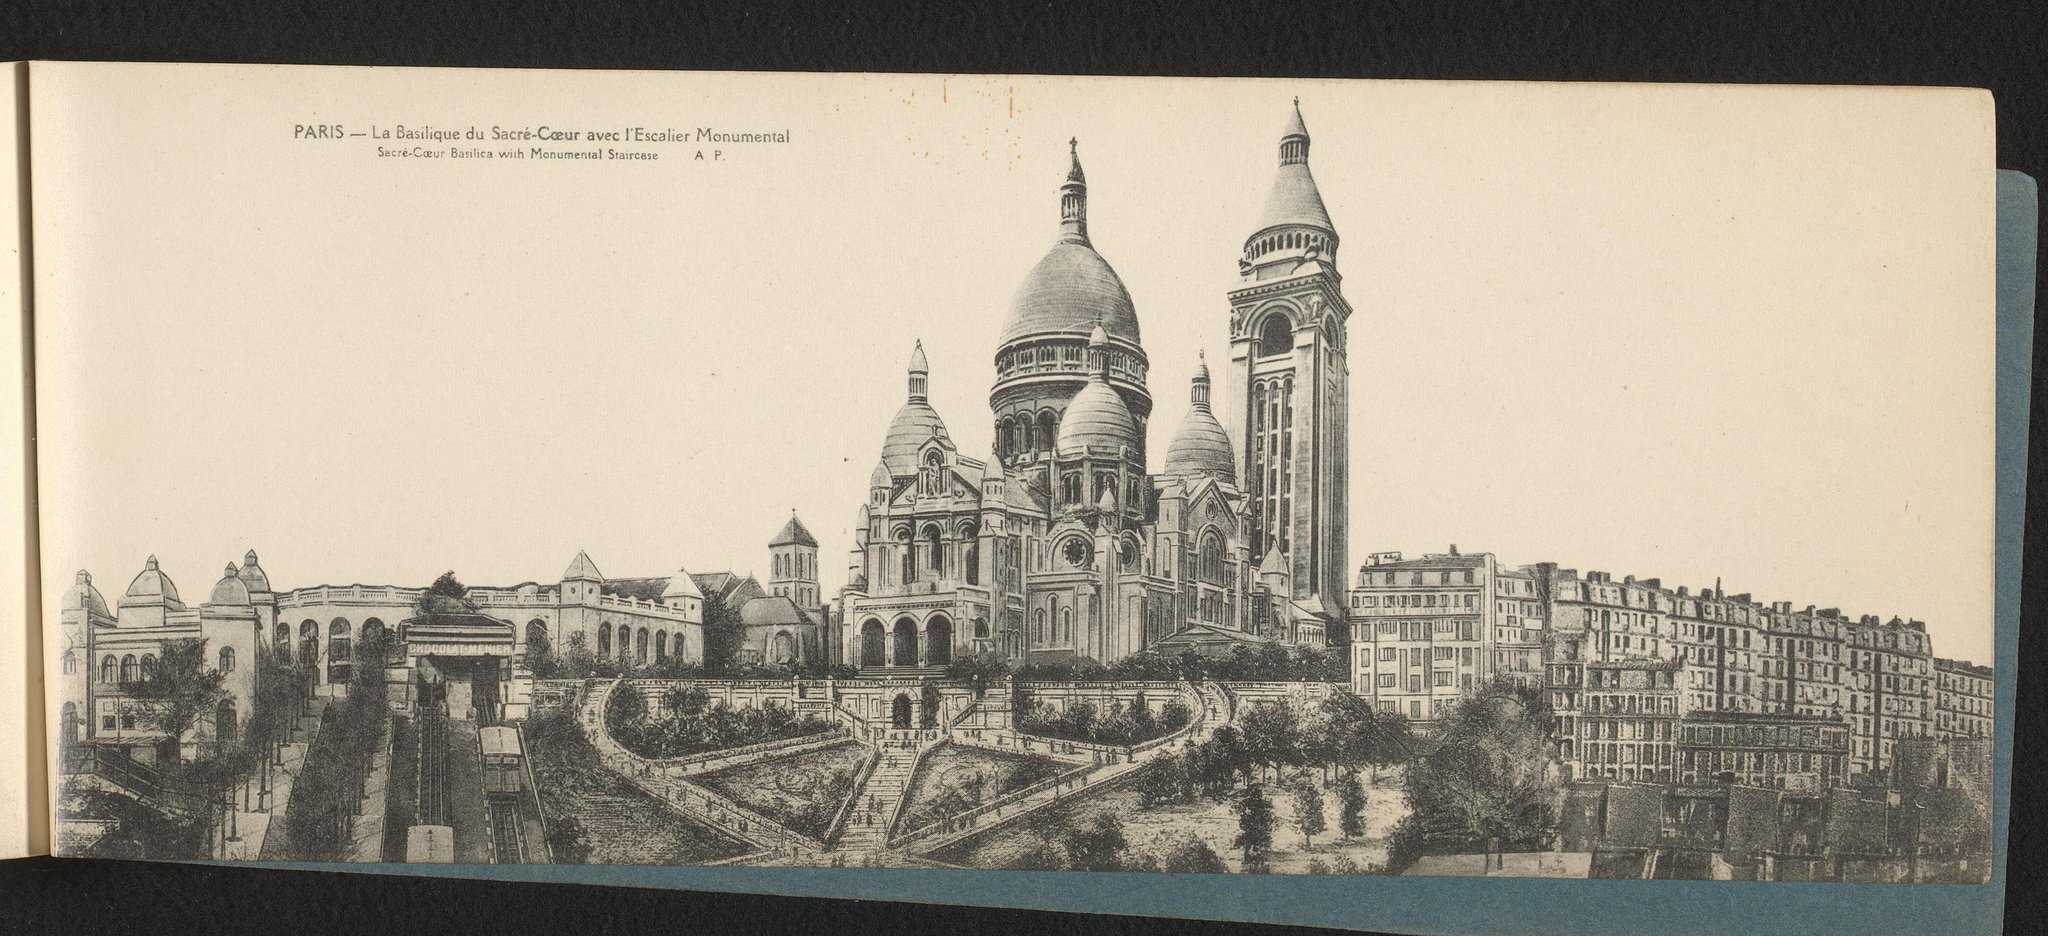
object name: photomechanical print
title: Paris. La Basilique du Sacré-Coeur avec l'Escalier Monumental / Sacré-Coeur Basilica with Monumental Staircase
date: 1910-1925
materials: cardboard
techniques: photograph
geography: paris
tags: sloping street; street with steps or stairs, church (exterior), city-view, and landscape with man-made constructions (+ city(-scape) with figures, staffage)